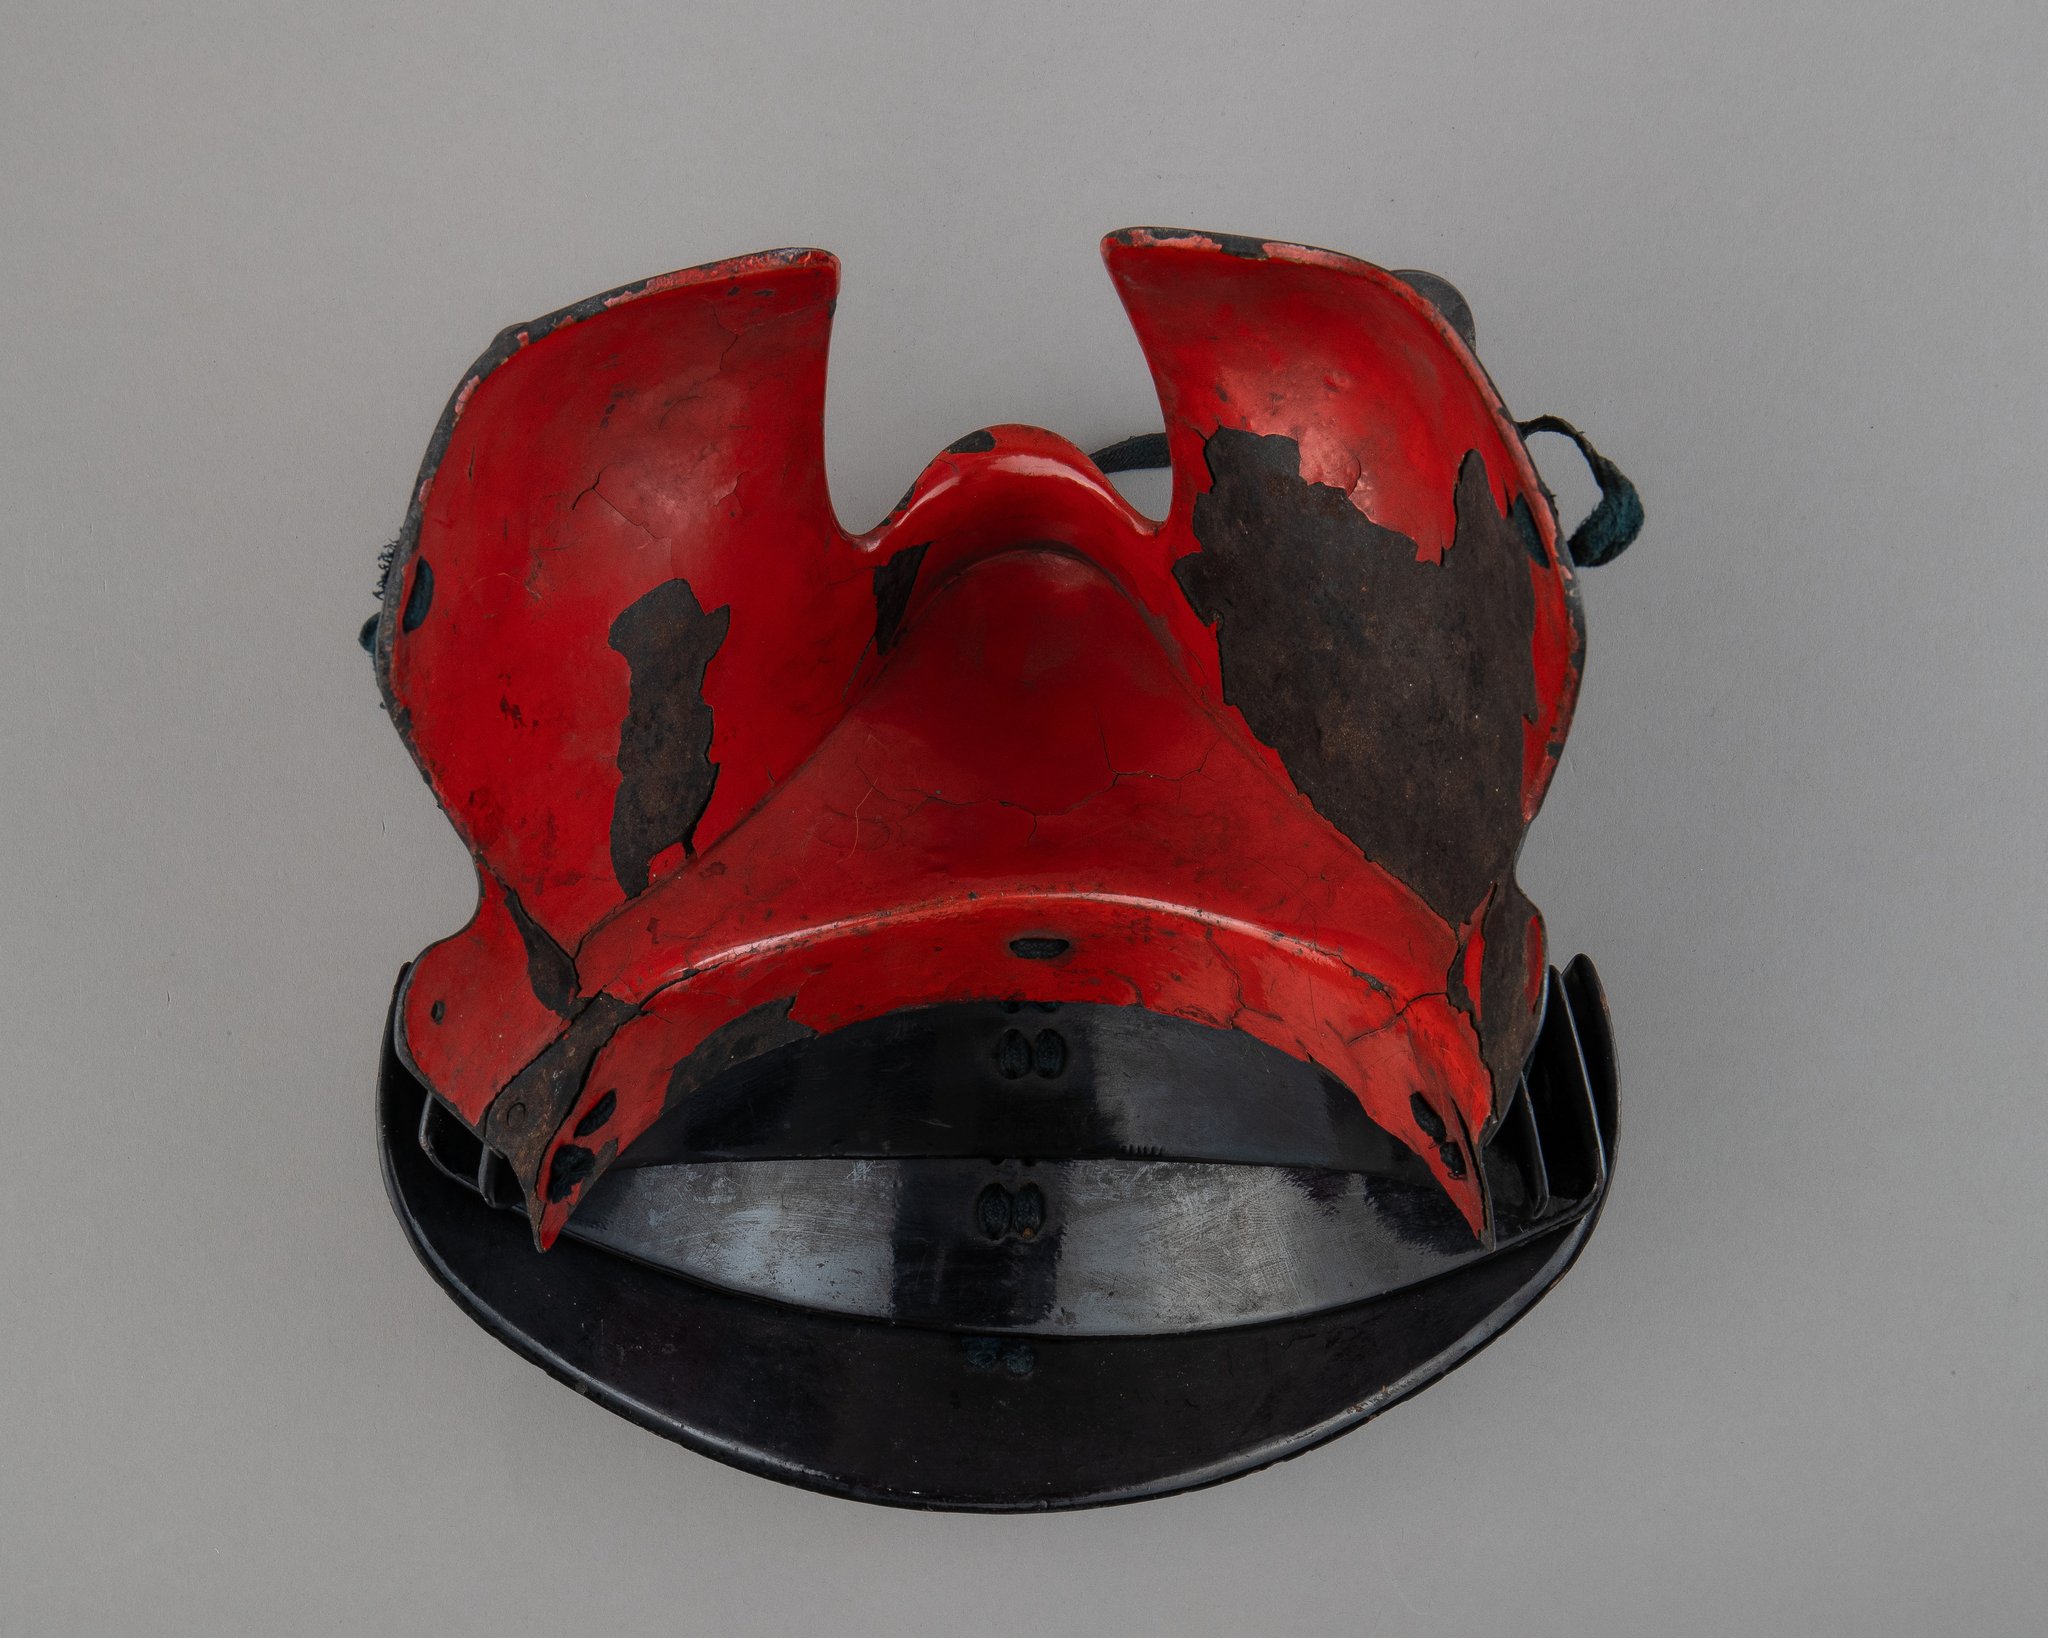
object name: half mask menpō with gorget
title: Half Mask (Menpō) with Gorget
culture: japanese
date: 1615-1868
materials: iron, lacquer, silk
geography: japan